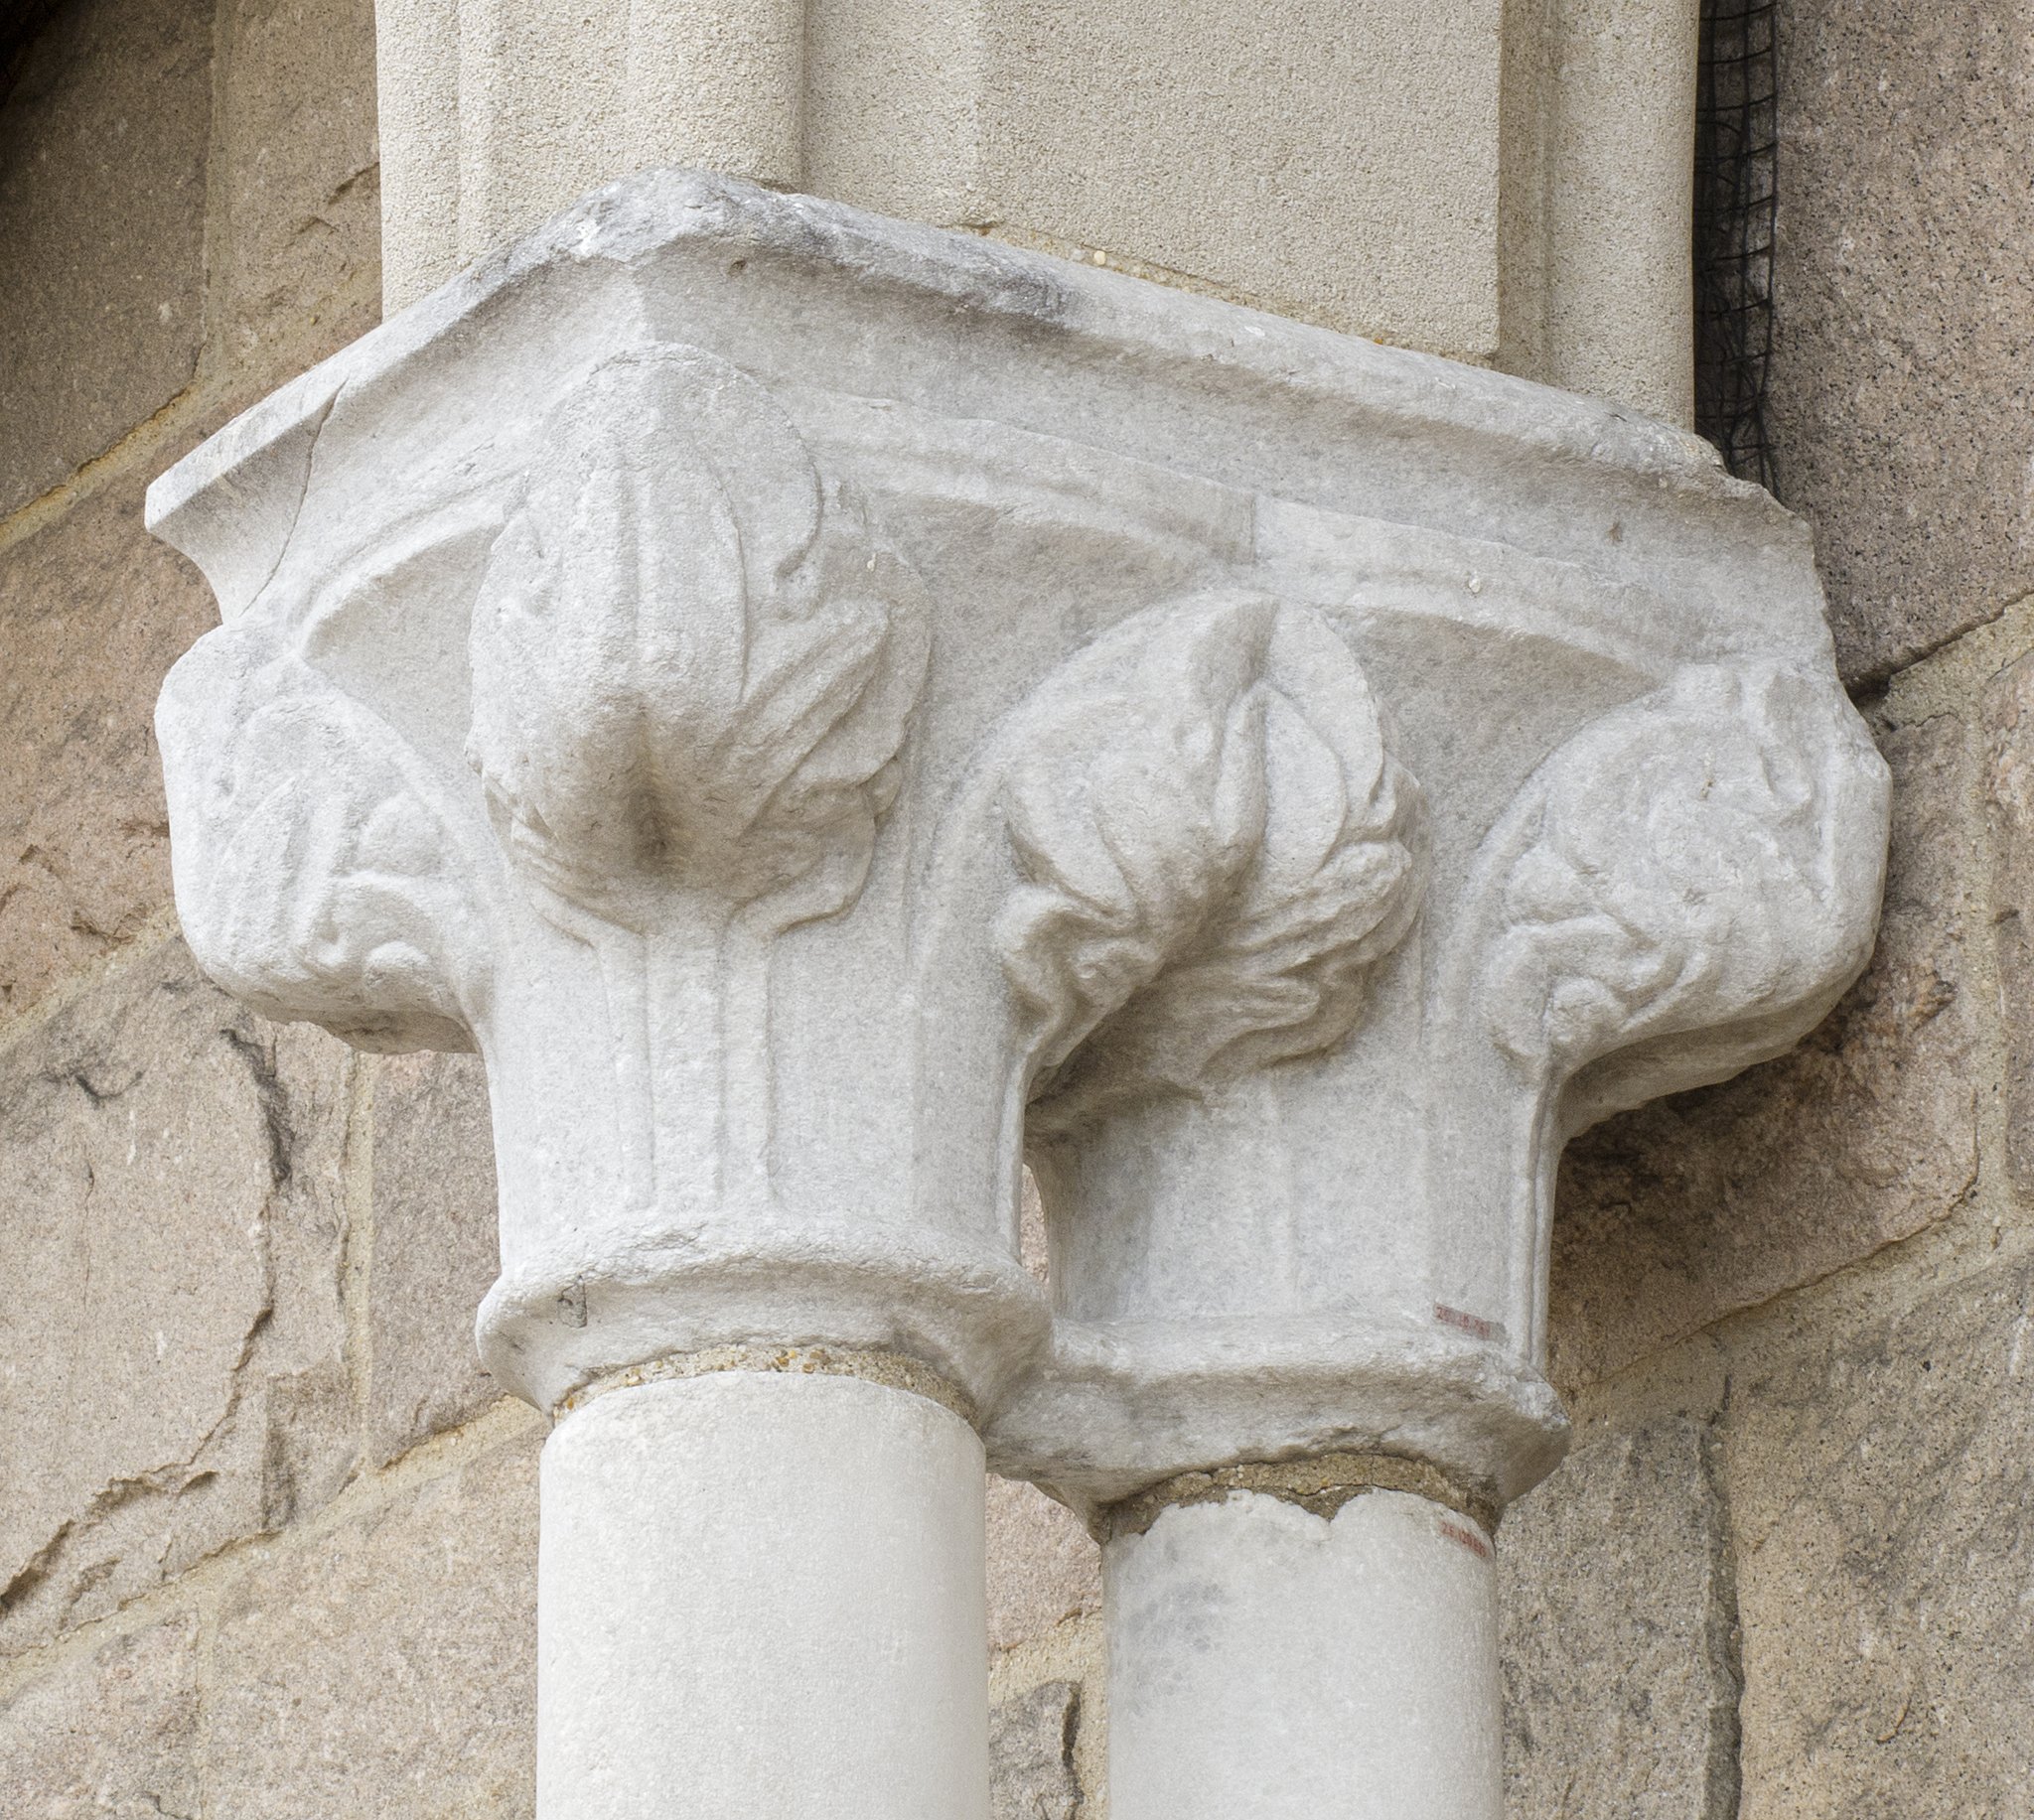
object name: capital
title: Double Capital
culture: french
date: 1267-1333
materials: marble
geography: france